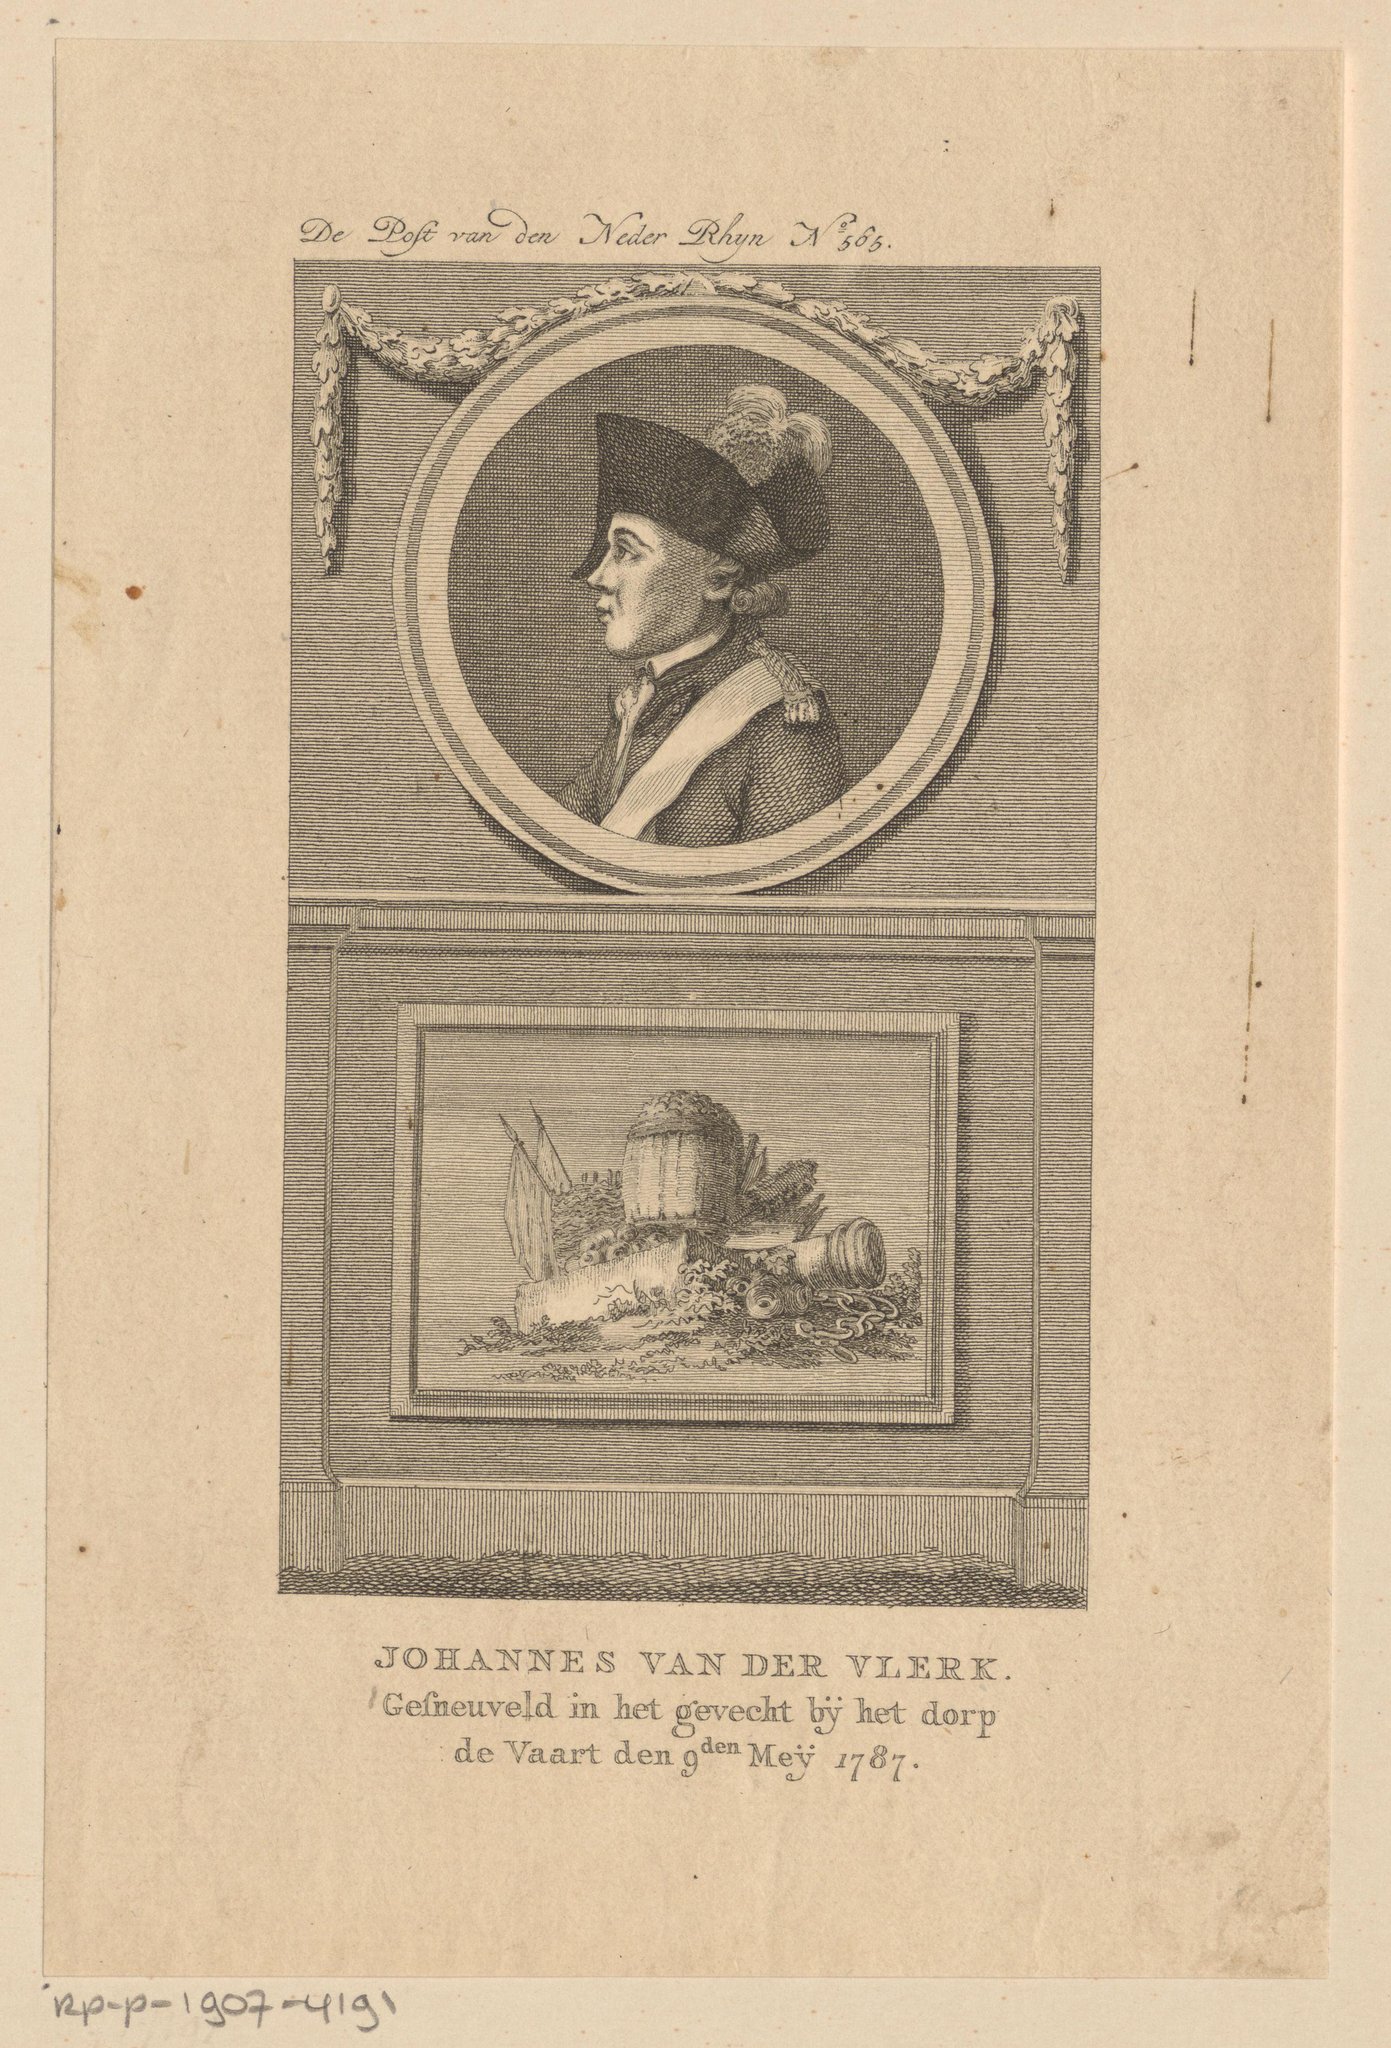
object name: print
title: Johannes van der Vlerk. Gesneuveld in het gevecht by het dorp de Vaart den 9den mey 1787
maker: Anonymous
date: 1787-1791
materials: paper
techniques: engraving, etching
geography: northern netherlands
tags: utrecht, historical persons, (military) attack, officer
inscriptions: collector's mark: Lugt 2228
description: Prent waarschijnlijk uit: De Post van den Neder-Rhyn (1787), Nr. 565. Prent ook gebruikt in: Rogge, Cornelis: Beknopte historie der onlusten in de Nederlanden (...). Brabant: s.n., 1790-1792.